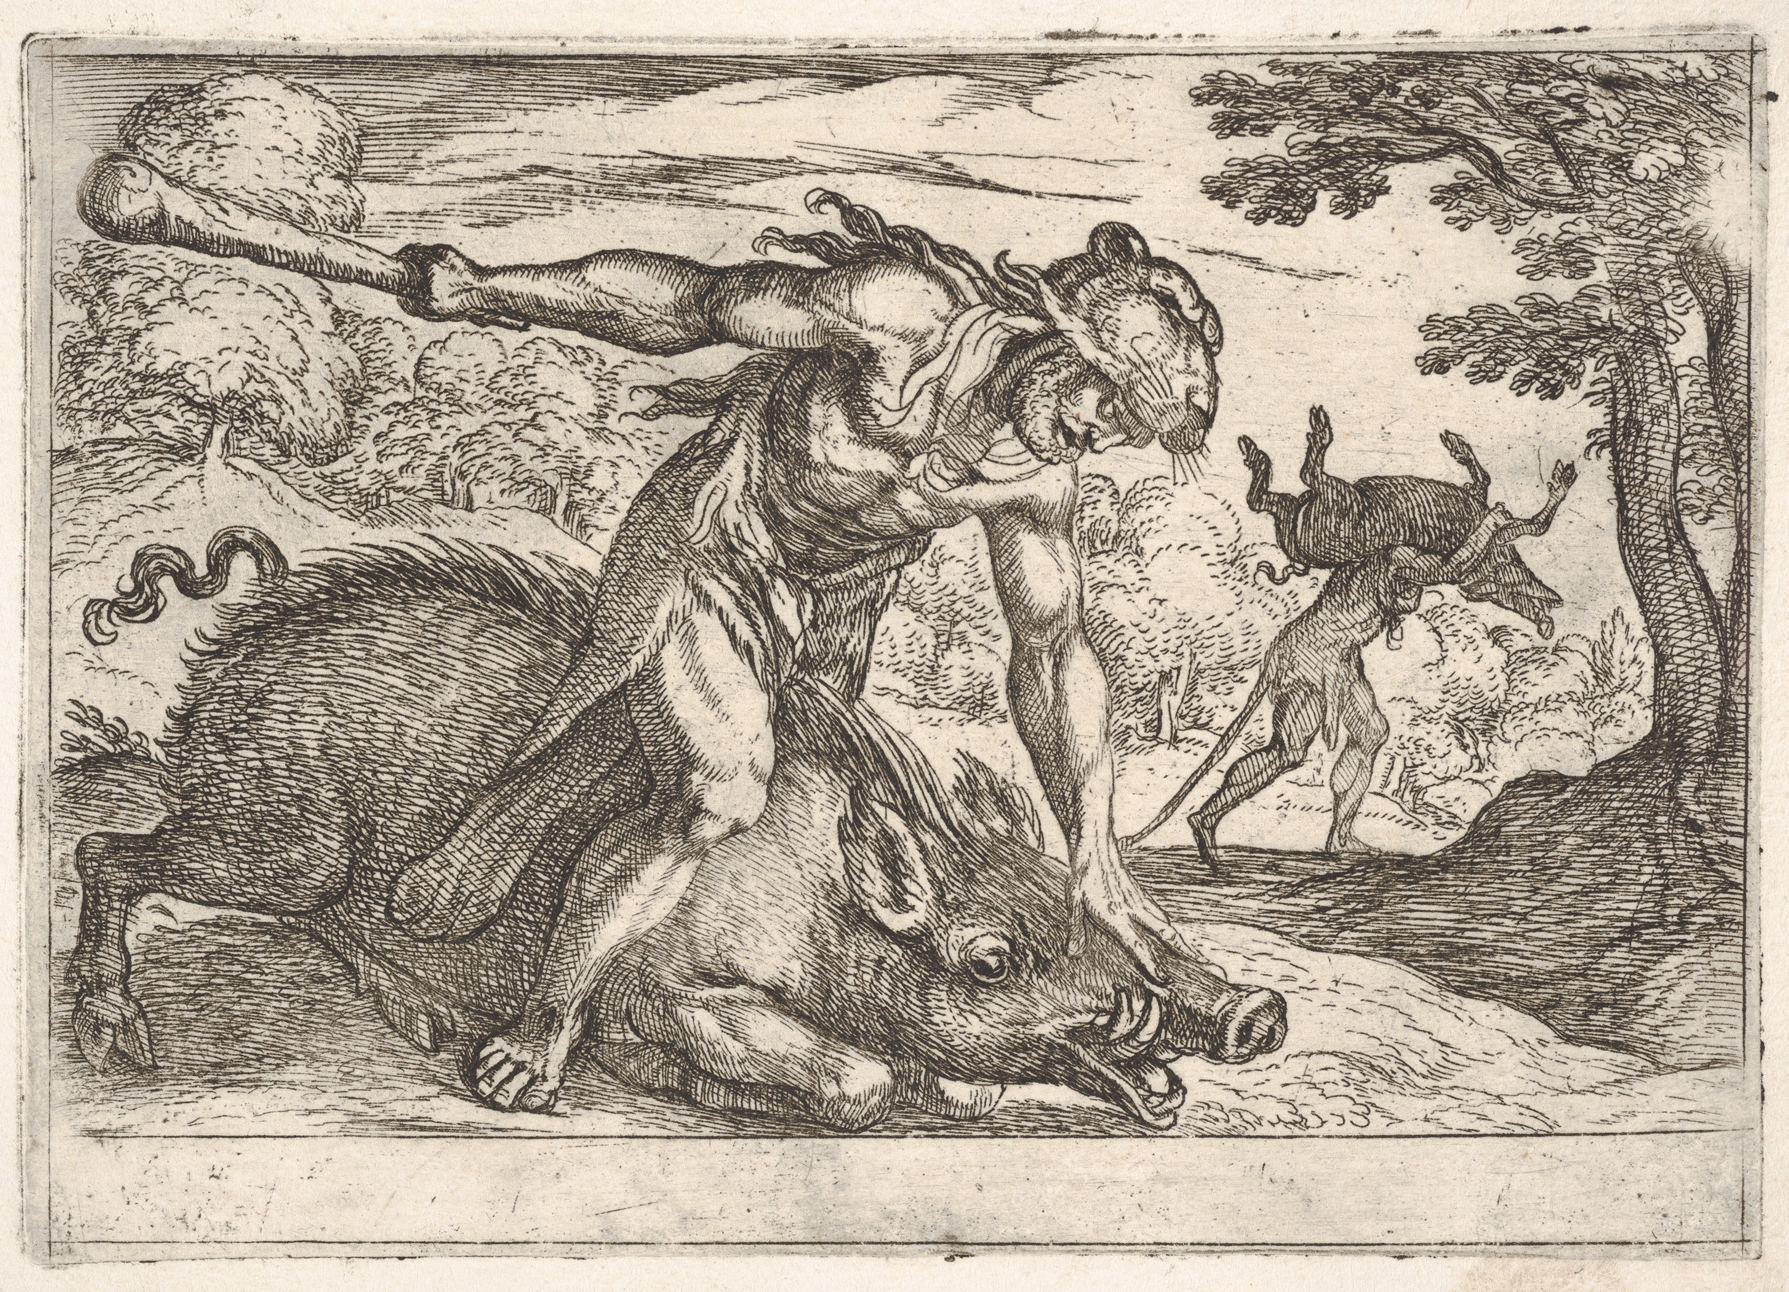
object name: print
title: Hercules and the Boar of Erymanthus, from "The Labors of Hercules"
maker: antonio tempesta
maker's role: artist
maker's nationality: italian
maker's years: 1555-1630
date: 1608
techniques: etching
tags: hercules,boars